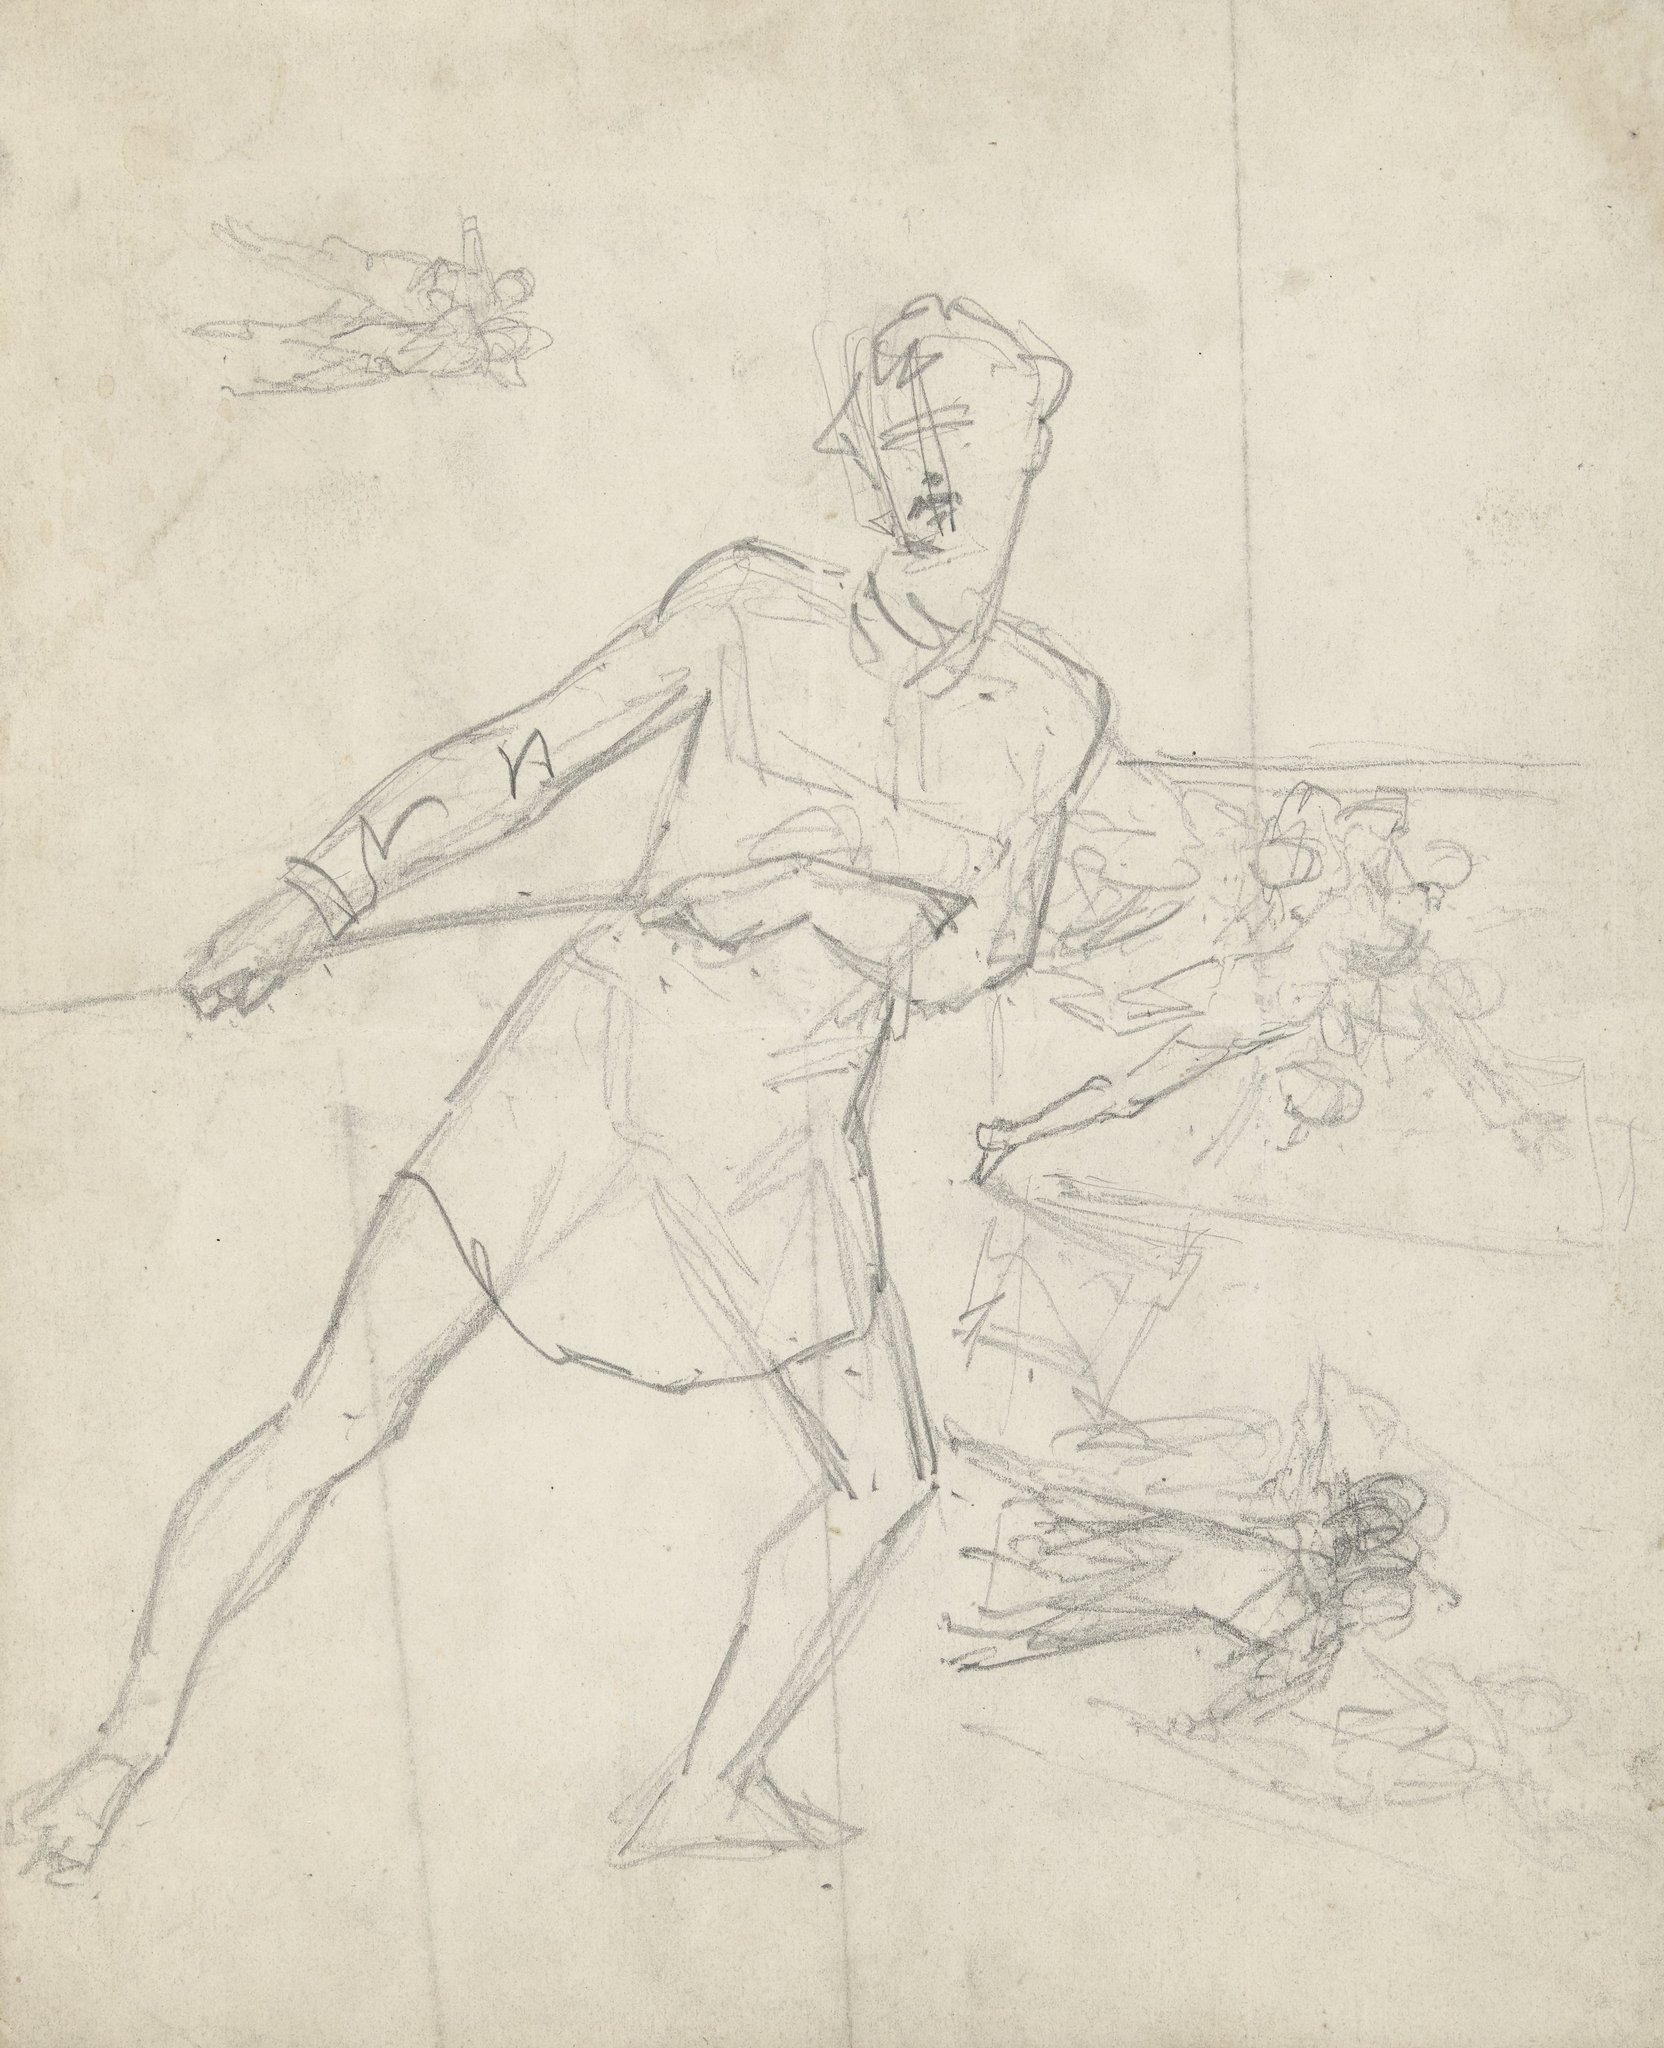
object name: design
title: Staande man die aan een touw trekt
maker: johan braakensiek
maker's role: draughtsman, print maker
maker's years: 1858-1940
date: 1868-1940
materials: paper, pencil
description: Staande man die aan een touw trekt; op de verso enige schetsjes. Mogelijk een ontwerp voor een prent.